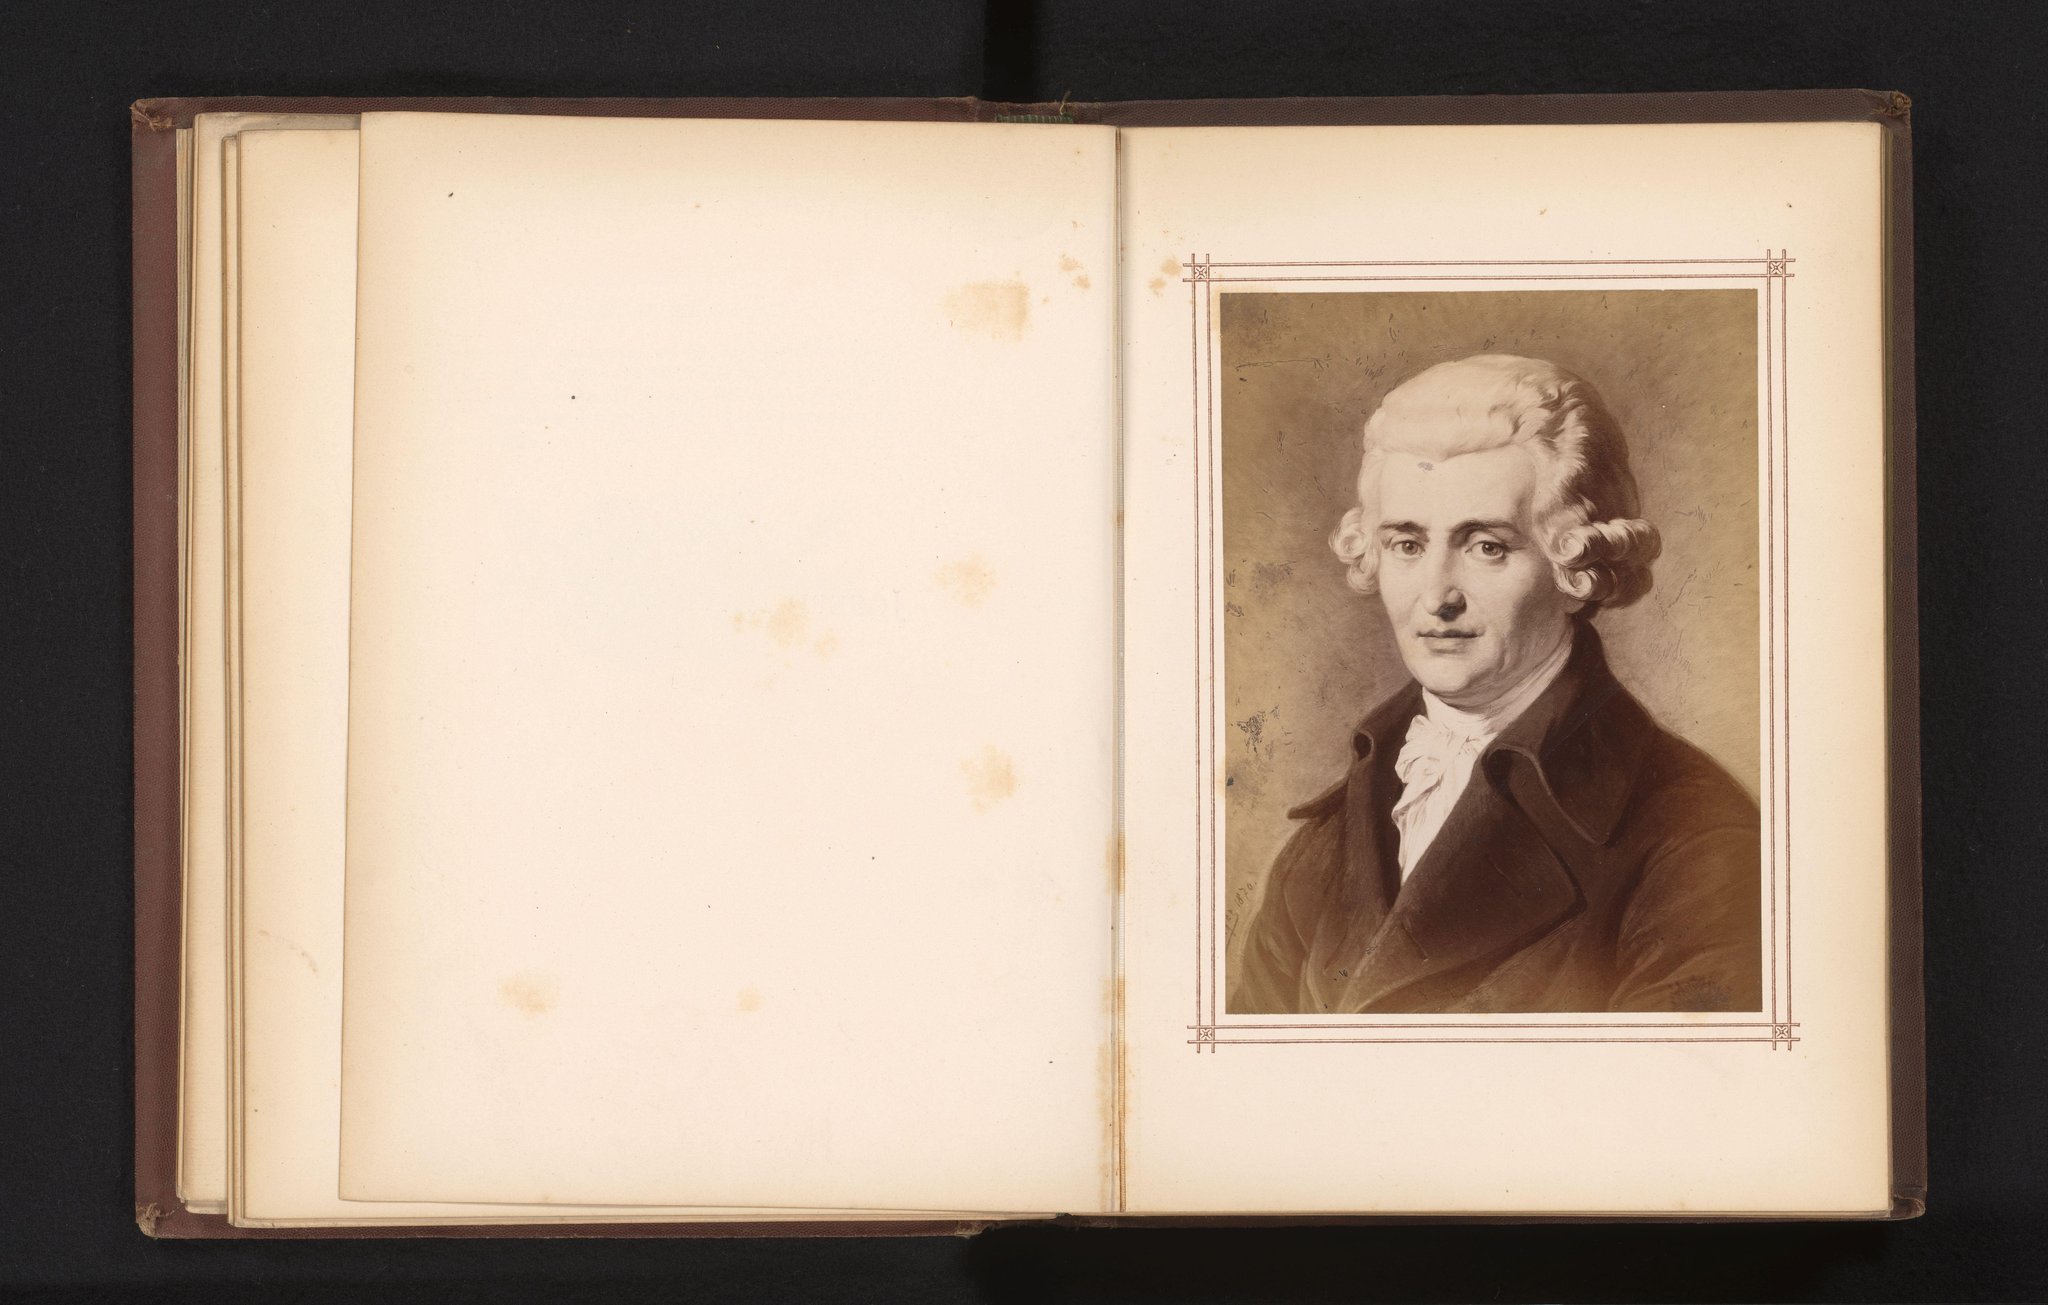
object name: photograph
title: Fotoreproductie van een portret van Franz Joseph Haydn door Carl Jaeger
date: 1865-1875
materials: photographic support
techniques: albumen print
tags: vienna, composer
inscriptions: name: ‘[...]er 1870’